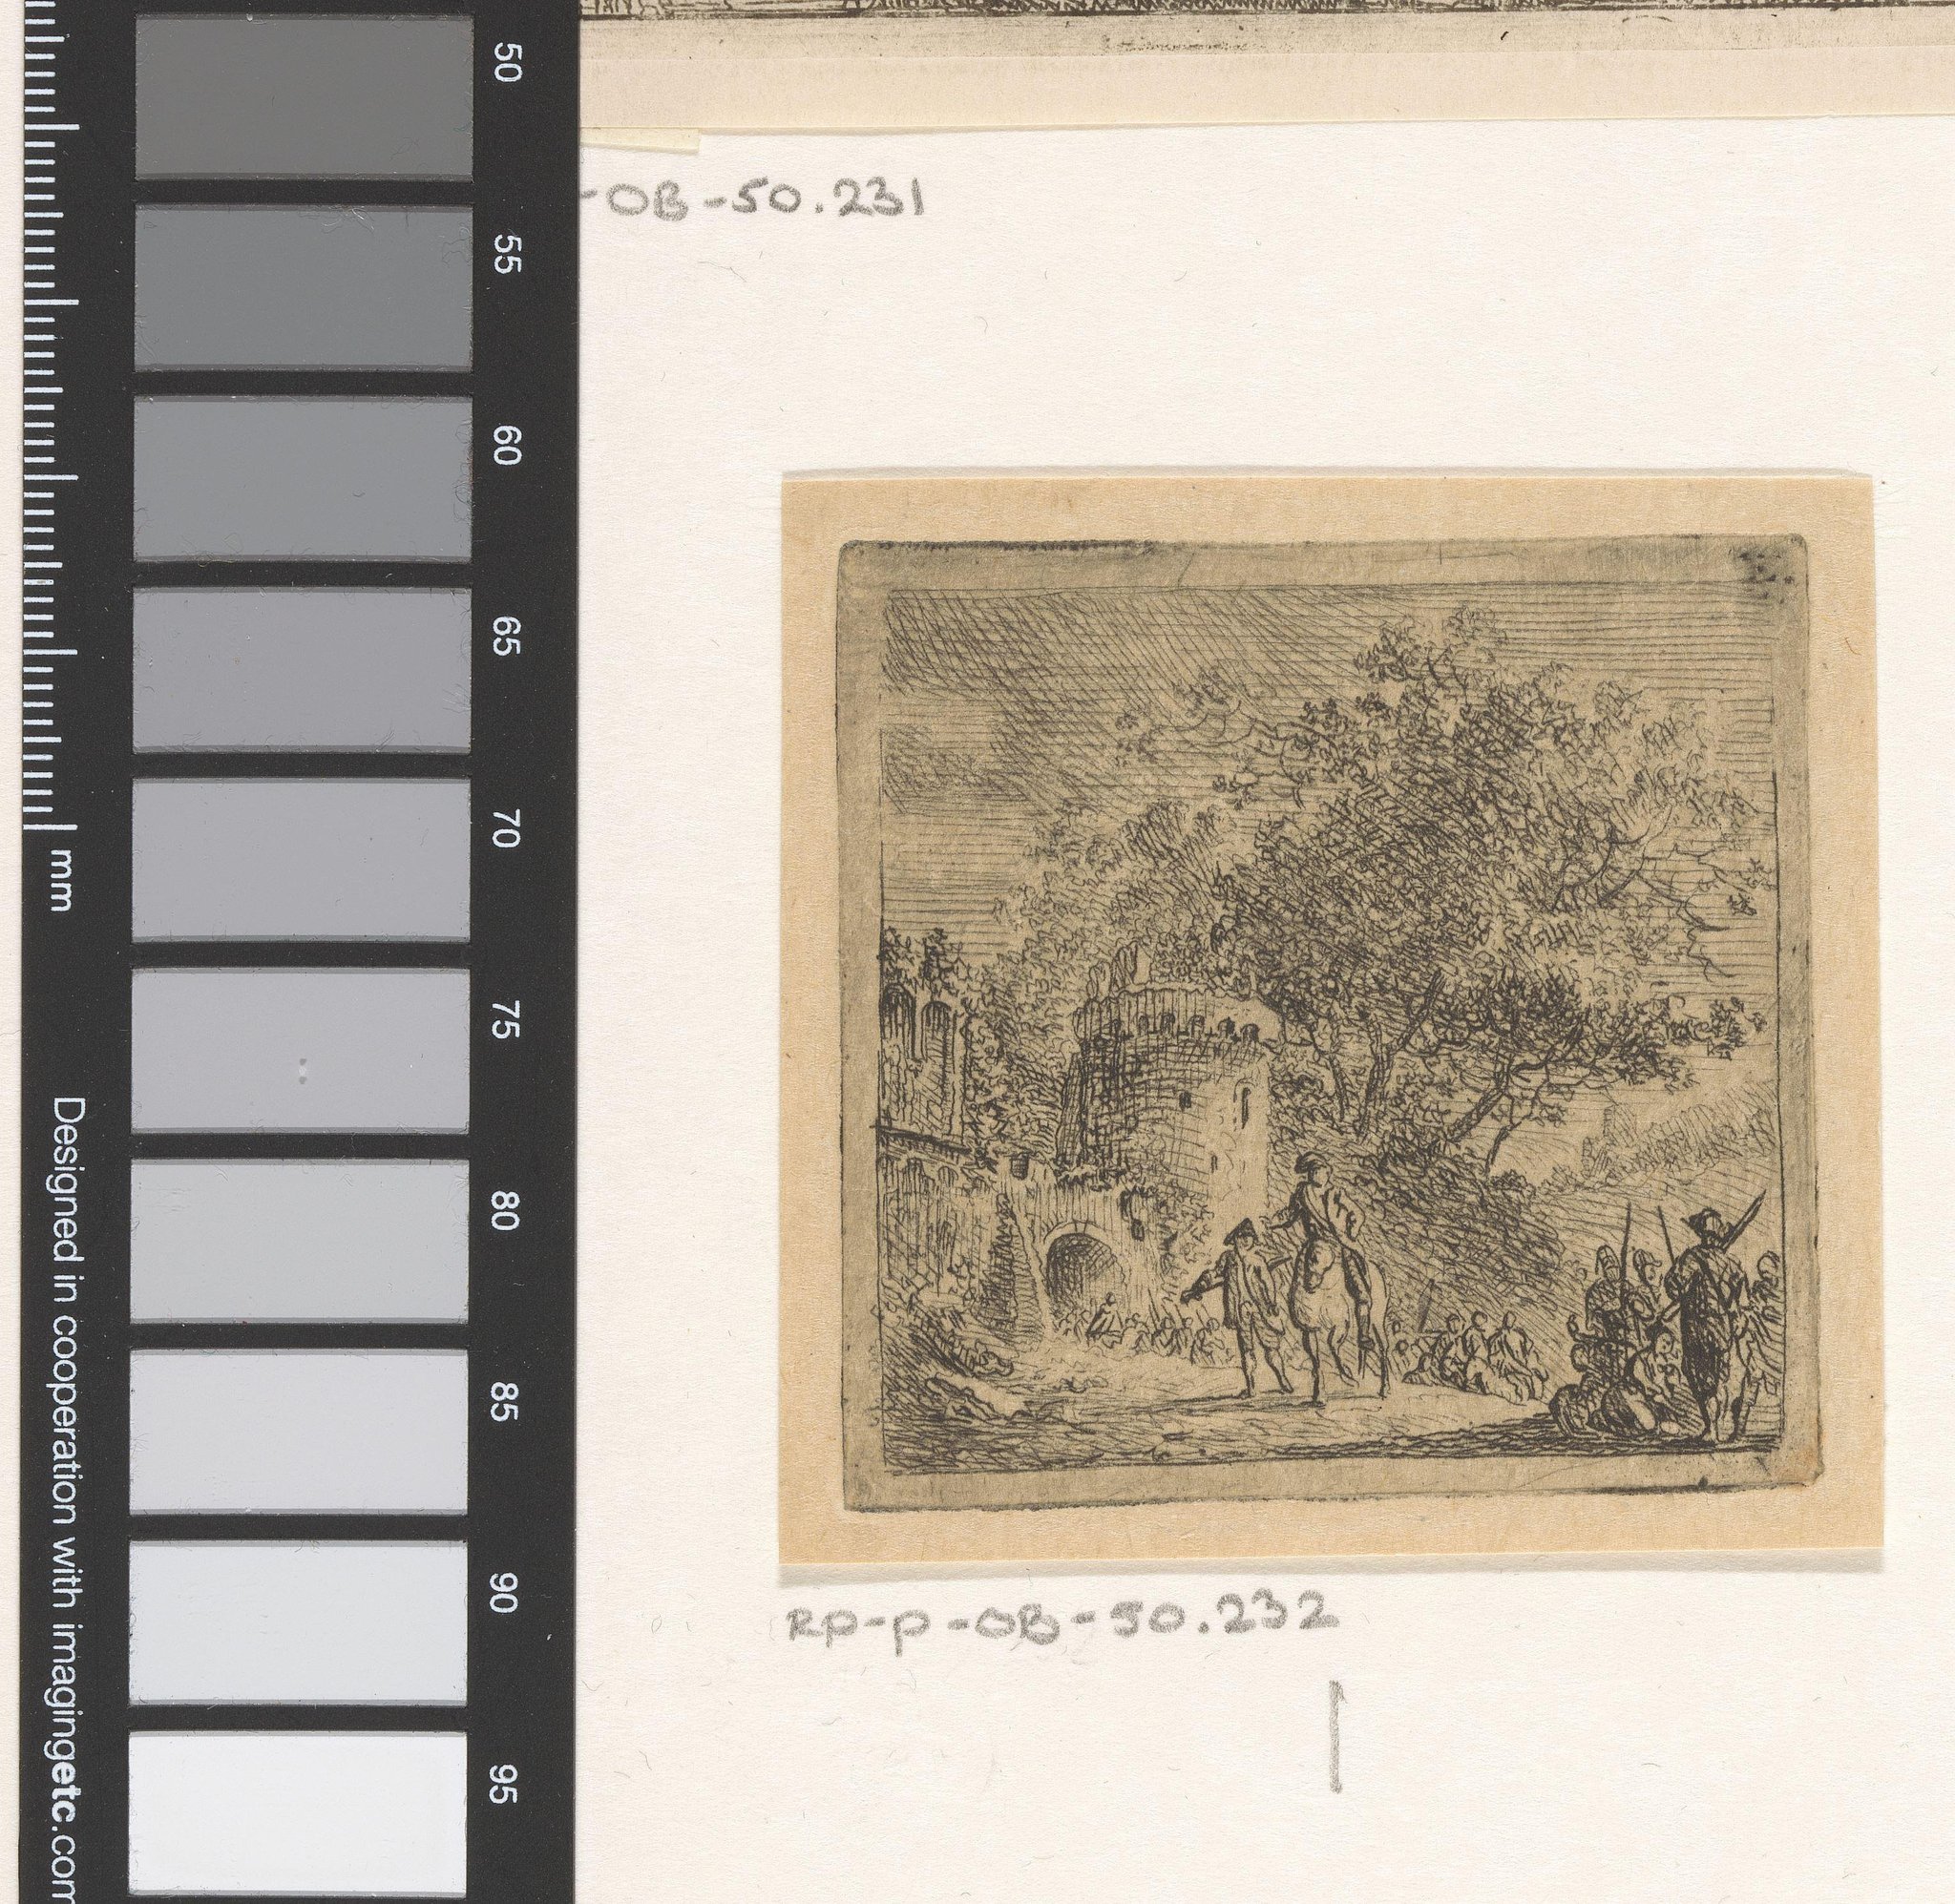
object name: print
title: Ruiter bij een fort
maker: gerardus emaus de micault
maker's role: draughtsman, print maker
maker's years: 1798-1863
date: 1813-1863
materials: paper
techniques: etching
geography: netherlands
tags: riding a horse, ass, or mule; rider, horseman (+ one person ~ traffic and transport)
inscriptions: collector's mark: Lugt 2228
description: Een man met steek rijdt naast een persoon te voet, langs een groep mensen. Op de achtergrond een fort waar ruiters uit rijden.